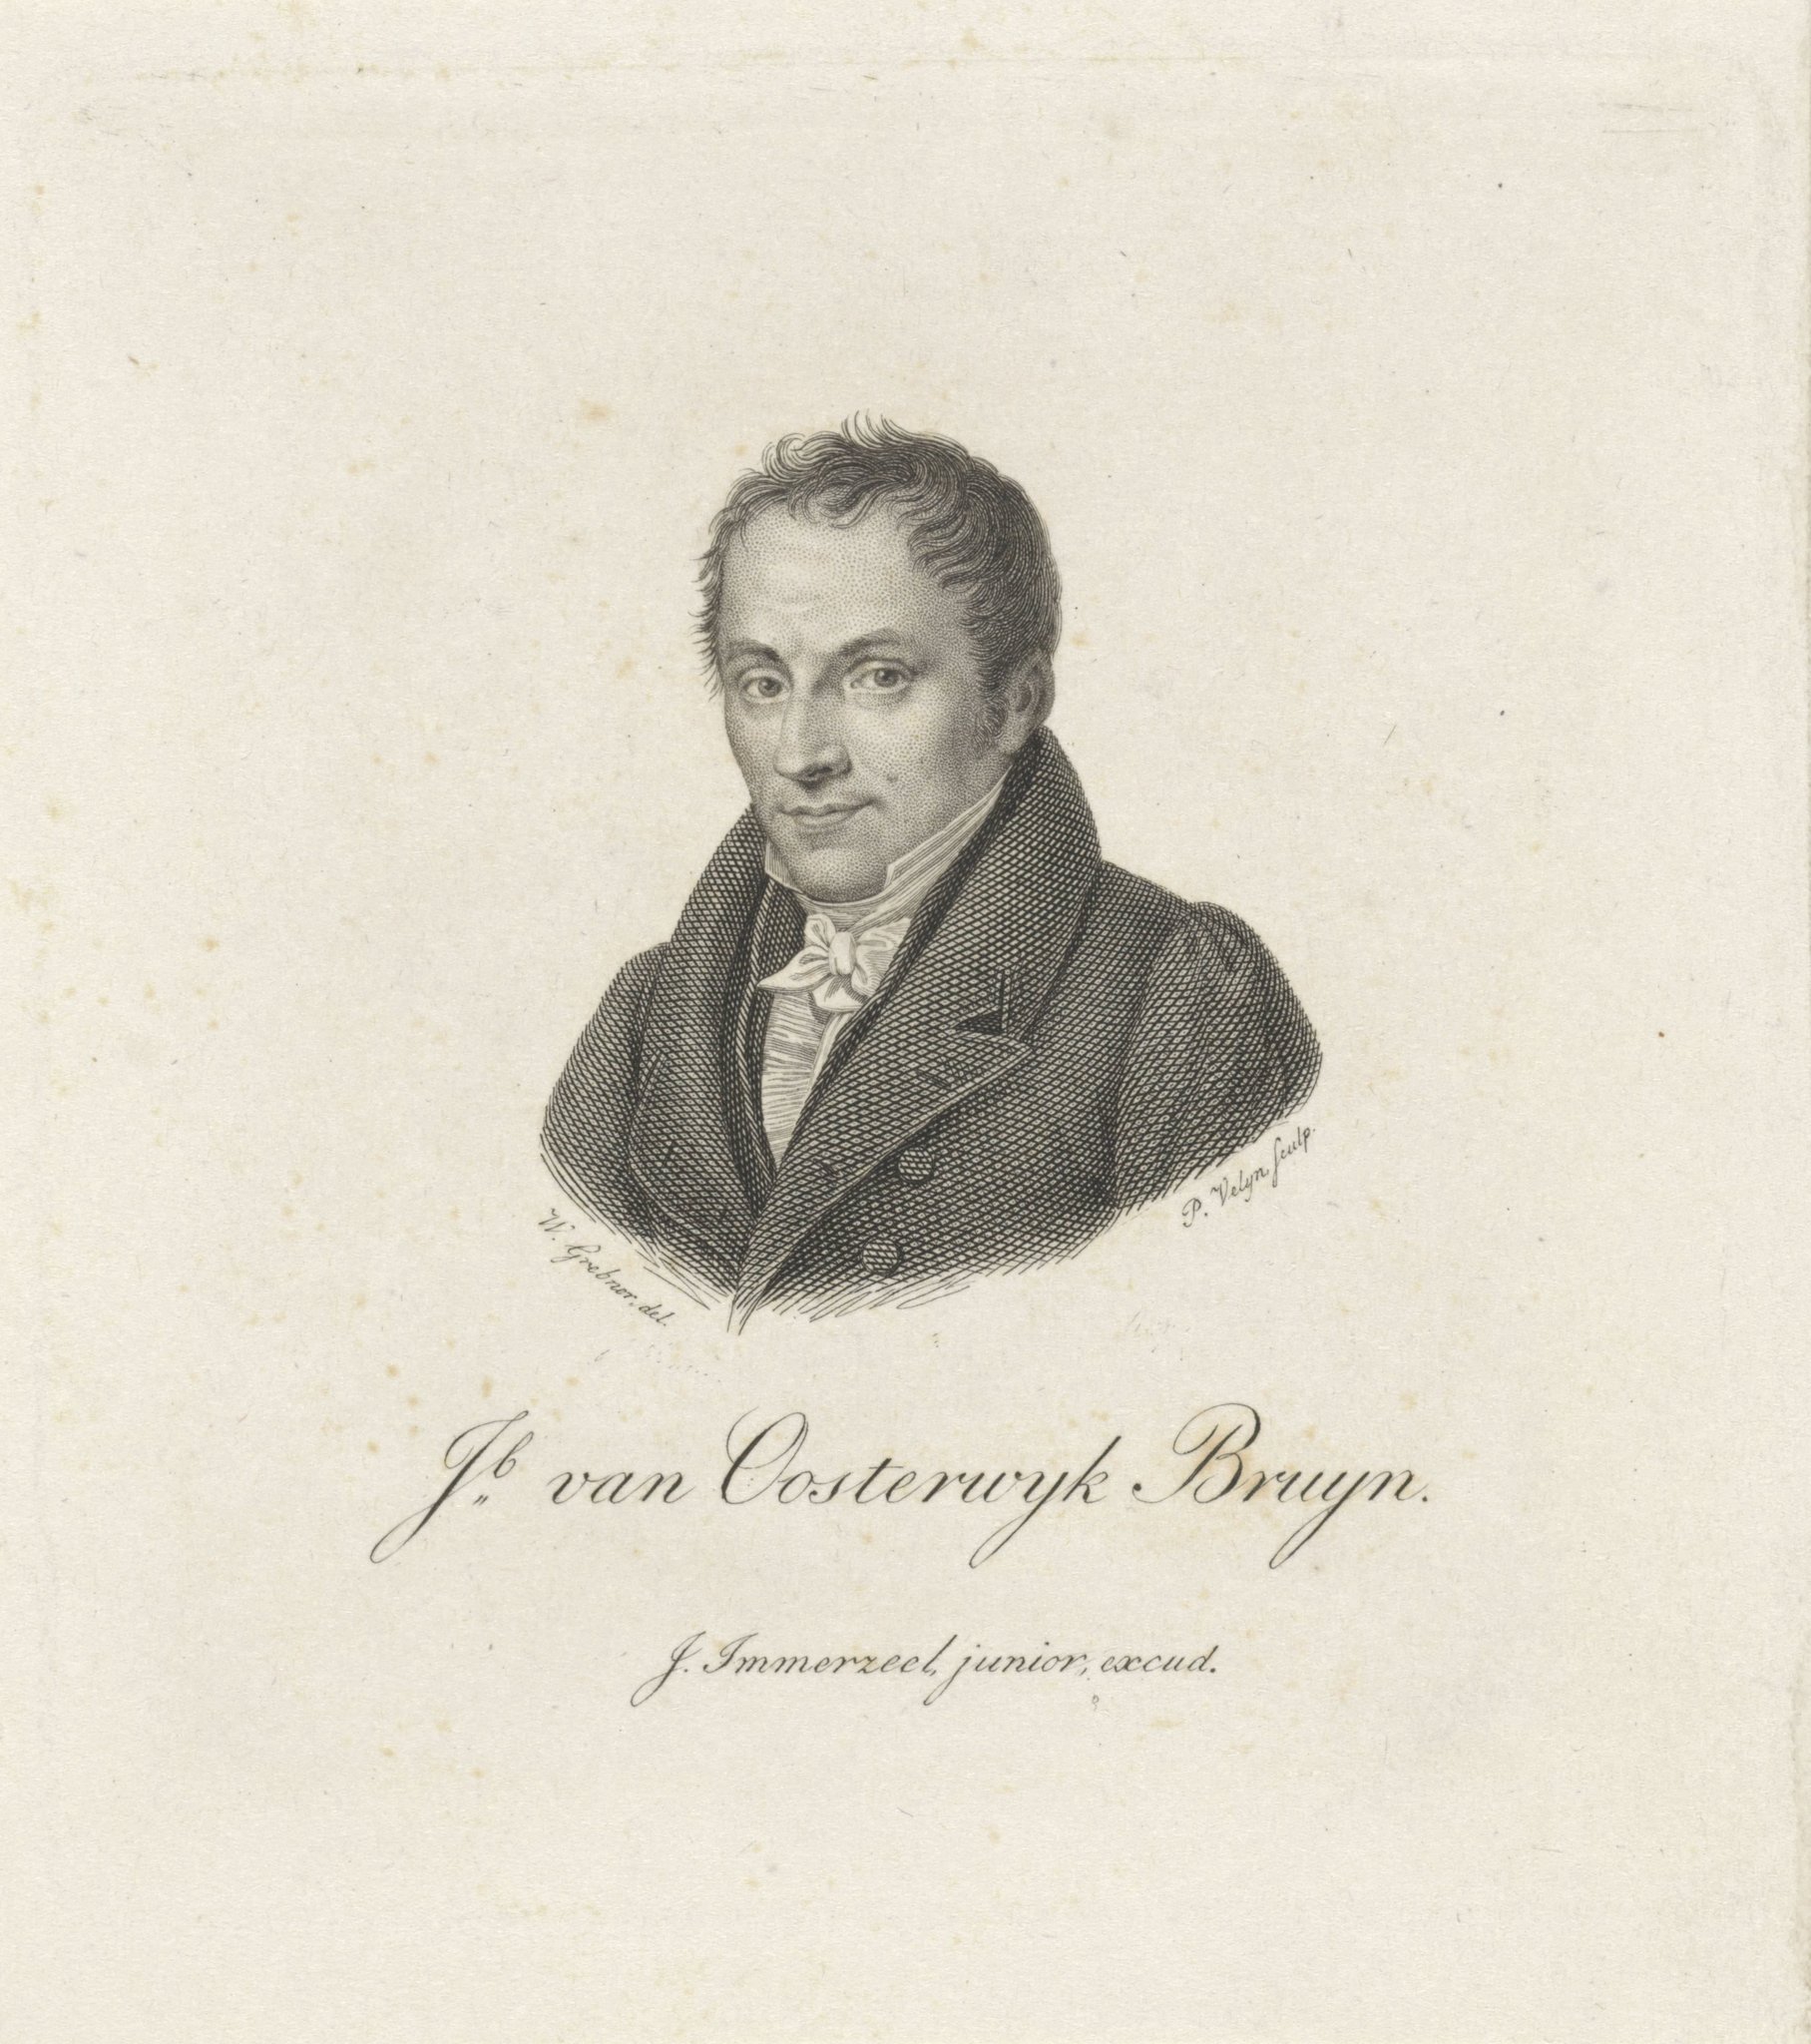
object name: print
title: Portret van Jacob van Oosterwijk Bruyn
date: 1833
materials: paper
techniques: engraving, etching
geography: netherlands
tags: amsterdam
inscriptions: collector's mark: Lugt 2228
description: Volgens Van Someren prent gebruikt in: Nederlandsche Muzen-Almanak. J. Immerzeel, 1833.